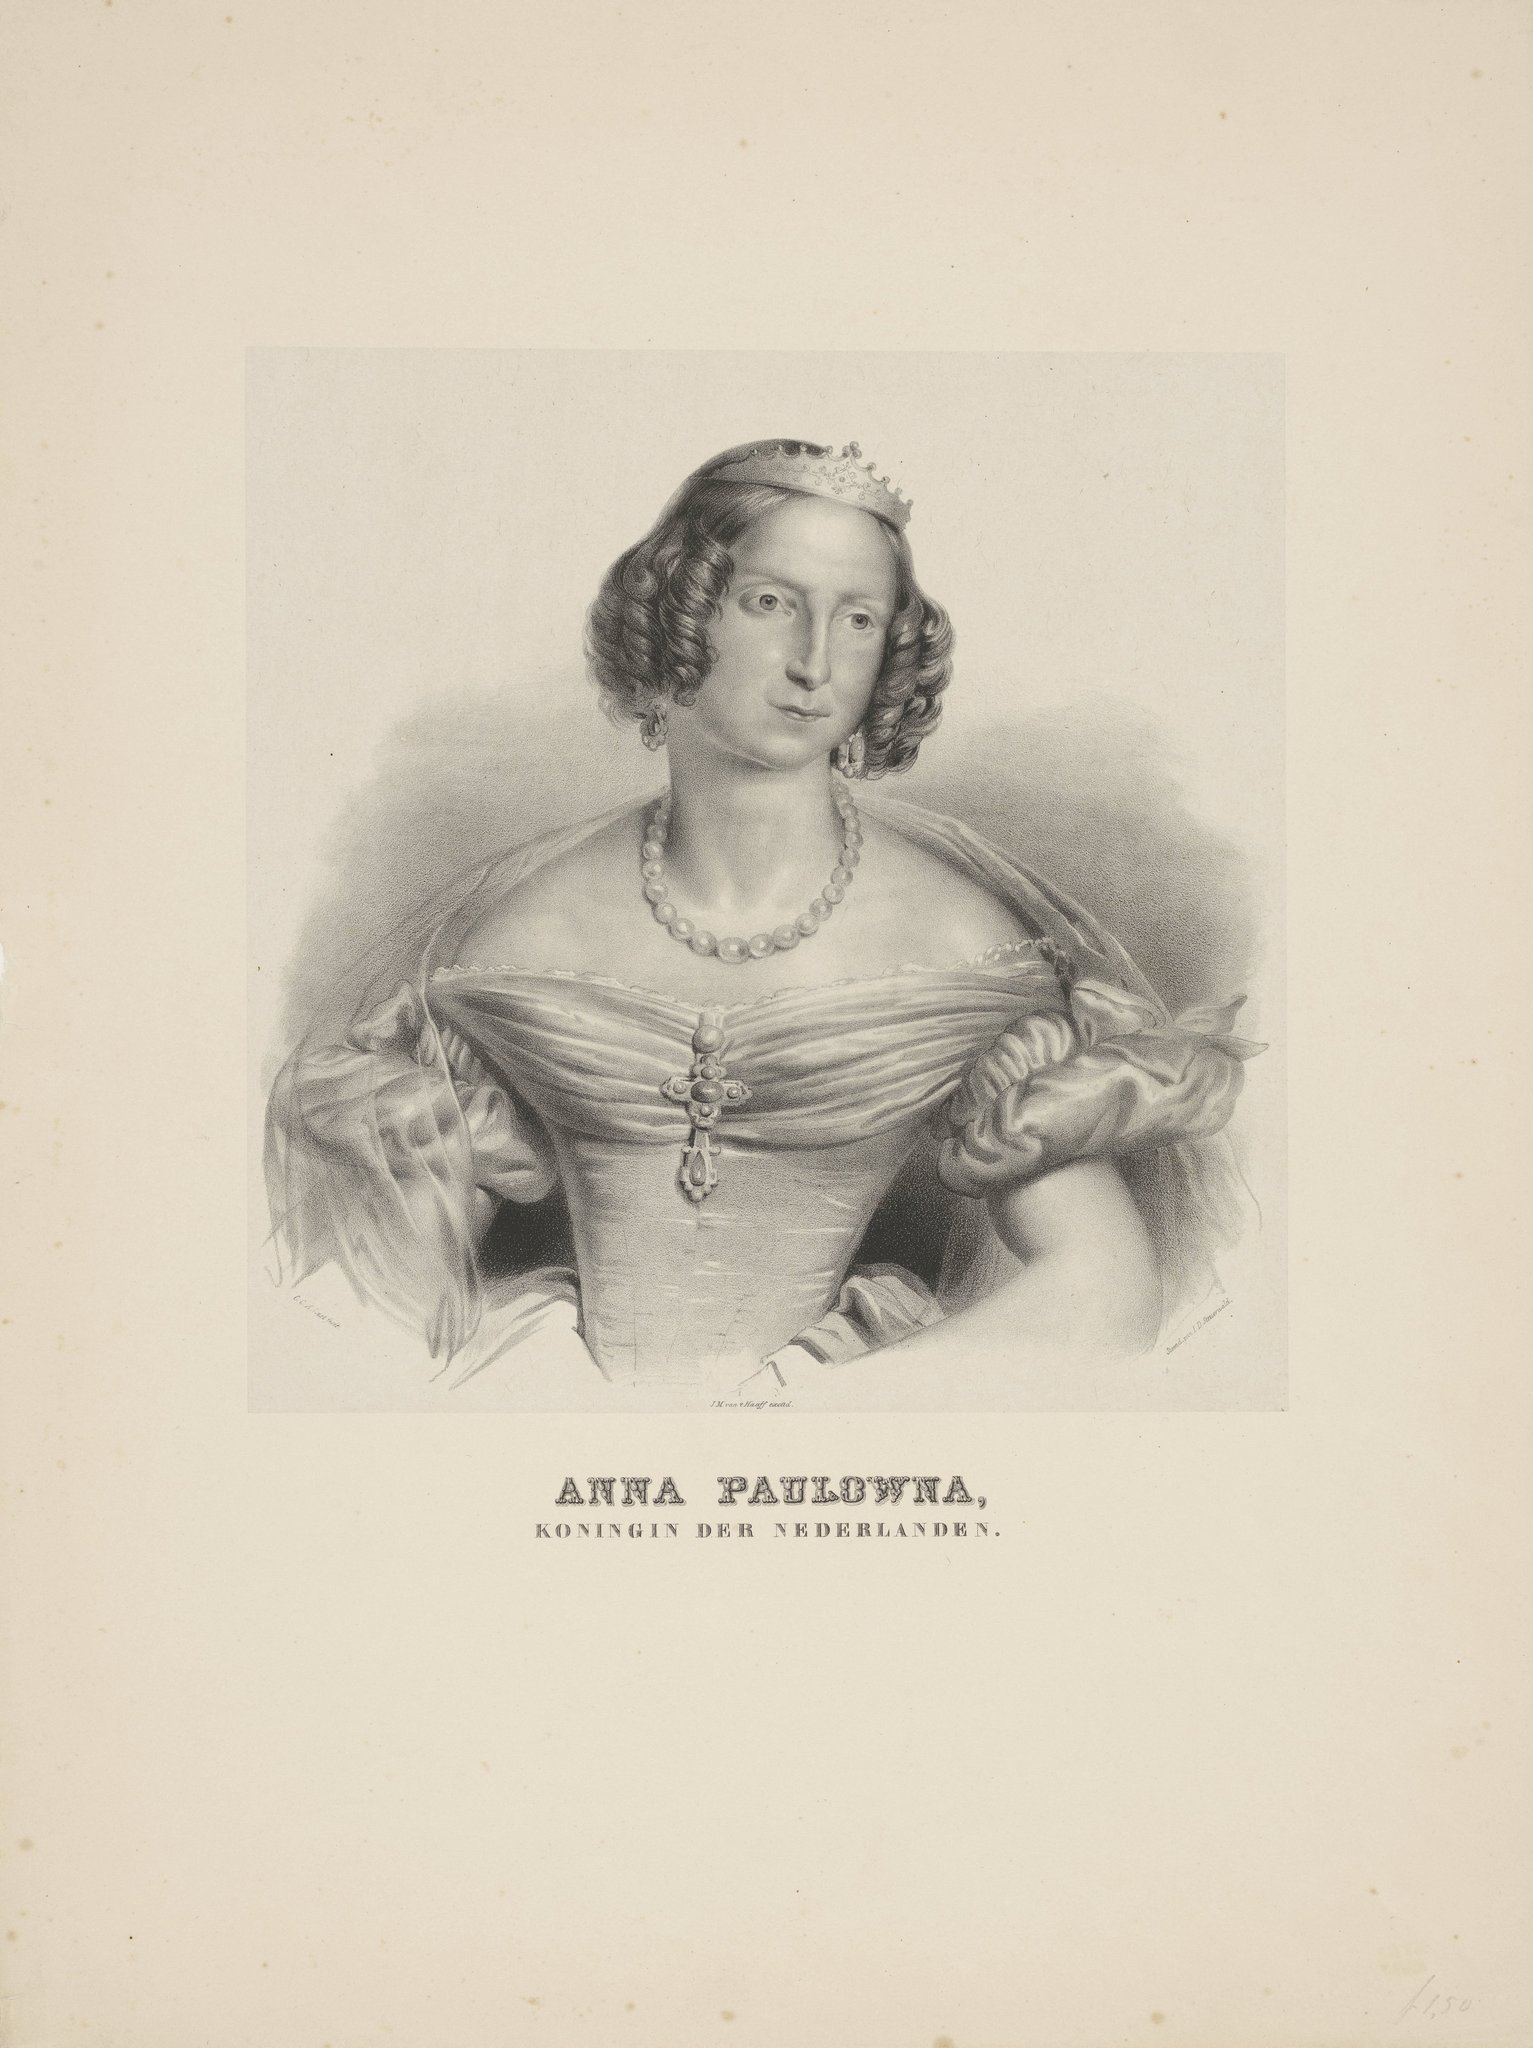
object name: print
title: Portret van Anna Paulowna Romanowa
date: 1840-1863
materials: paper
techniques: lithograph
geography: the hague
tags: anna paulowna romanowa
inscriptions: collector's mark: Lugt 2165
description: Portret van Anna Paulowna. In de ondermarge haar naam en titel.